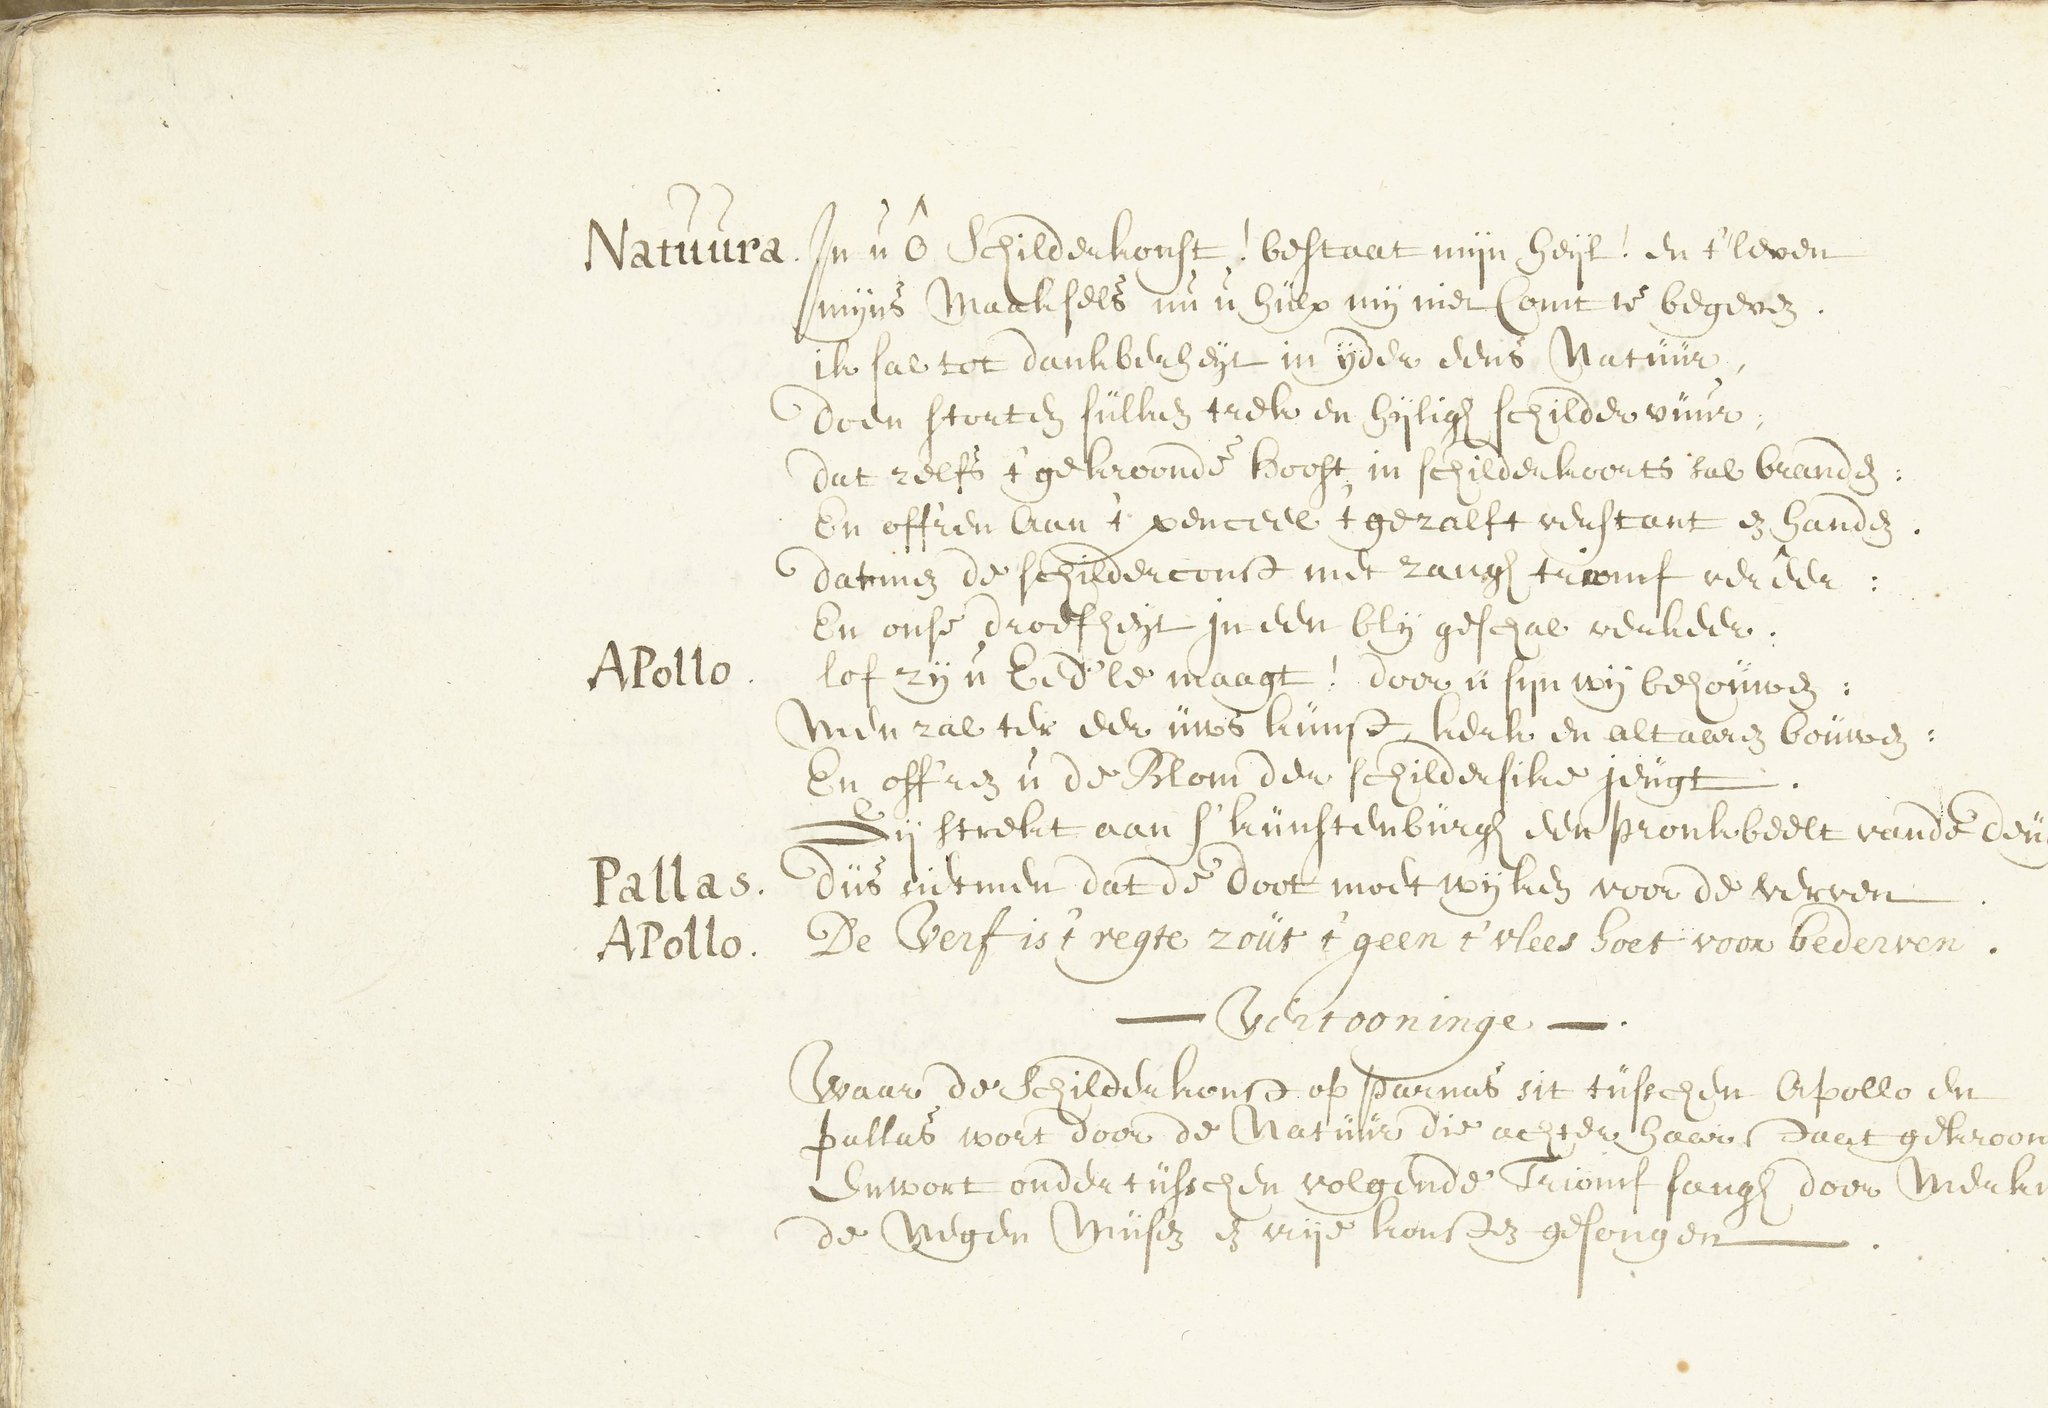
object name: text sheet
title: Strijd tussen Dood en Natuur of Zege der Schilderkunst (deel 20) en Vijfde vertoning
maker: henrik jordis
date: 1660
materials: ink, paper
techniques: writing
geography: zwolle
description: Vervolg van het toneelstuk Gooden Pleijdt ofte Triomphe der Schilderconst over de Doodt. Onderaan staat de laatste van vijf vertoningen, bedoeld om de opbouw en hoofdthema's van het toneelstuk uit te leggen. Deze laatse vertoning beschrijft hoe Schilderkunst bekroond word door Natuur en geflankeerd wordt door Apollo en Pallas. De negen muzen en de Vrije Kunsten, vergezeld door Mercurius, zingen allen een hymne voor Schilderkunst, de enige kracht die de strijd met de Dood kan trotseren.